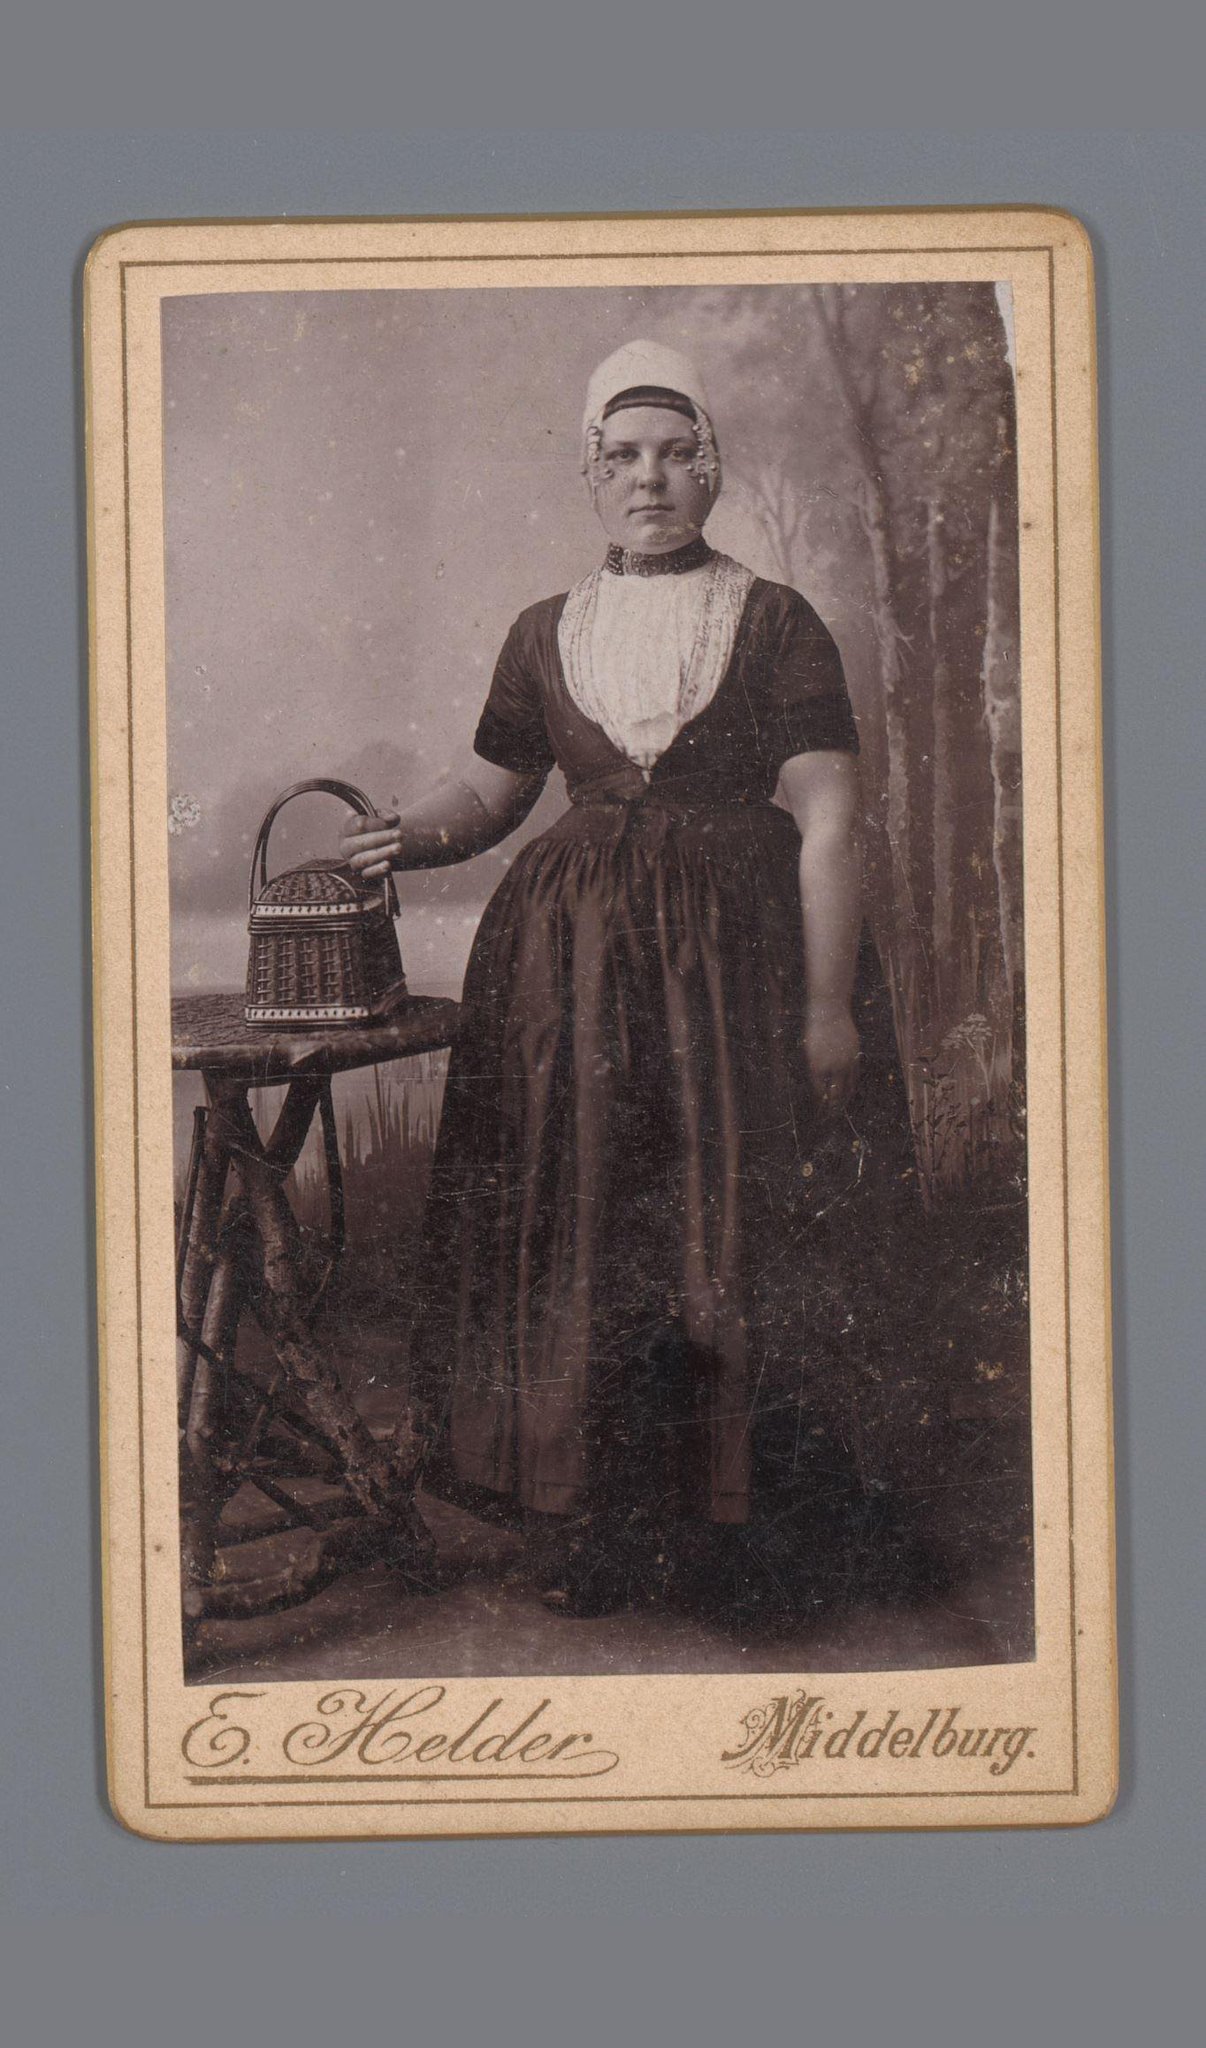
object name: carte de visite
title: Portret van een onbekende vrouw in Zeeuwse dracht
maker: eppe helder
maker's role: fotograaf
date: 1880-1920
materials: cardboard, photographic support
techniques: collodion silver print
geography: middelburg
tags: historical persons - bb - woman, folk costume, regional costume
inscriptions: inscription: ‘Eh/ Photographisch Atelier van/ E. Helder/MIDDELBURG/ Lange Delft J.34./’